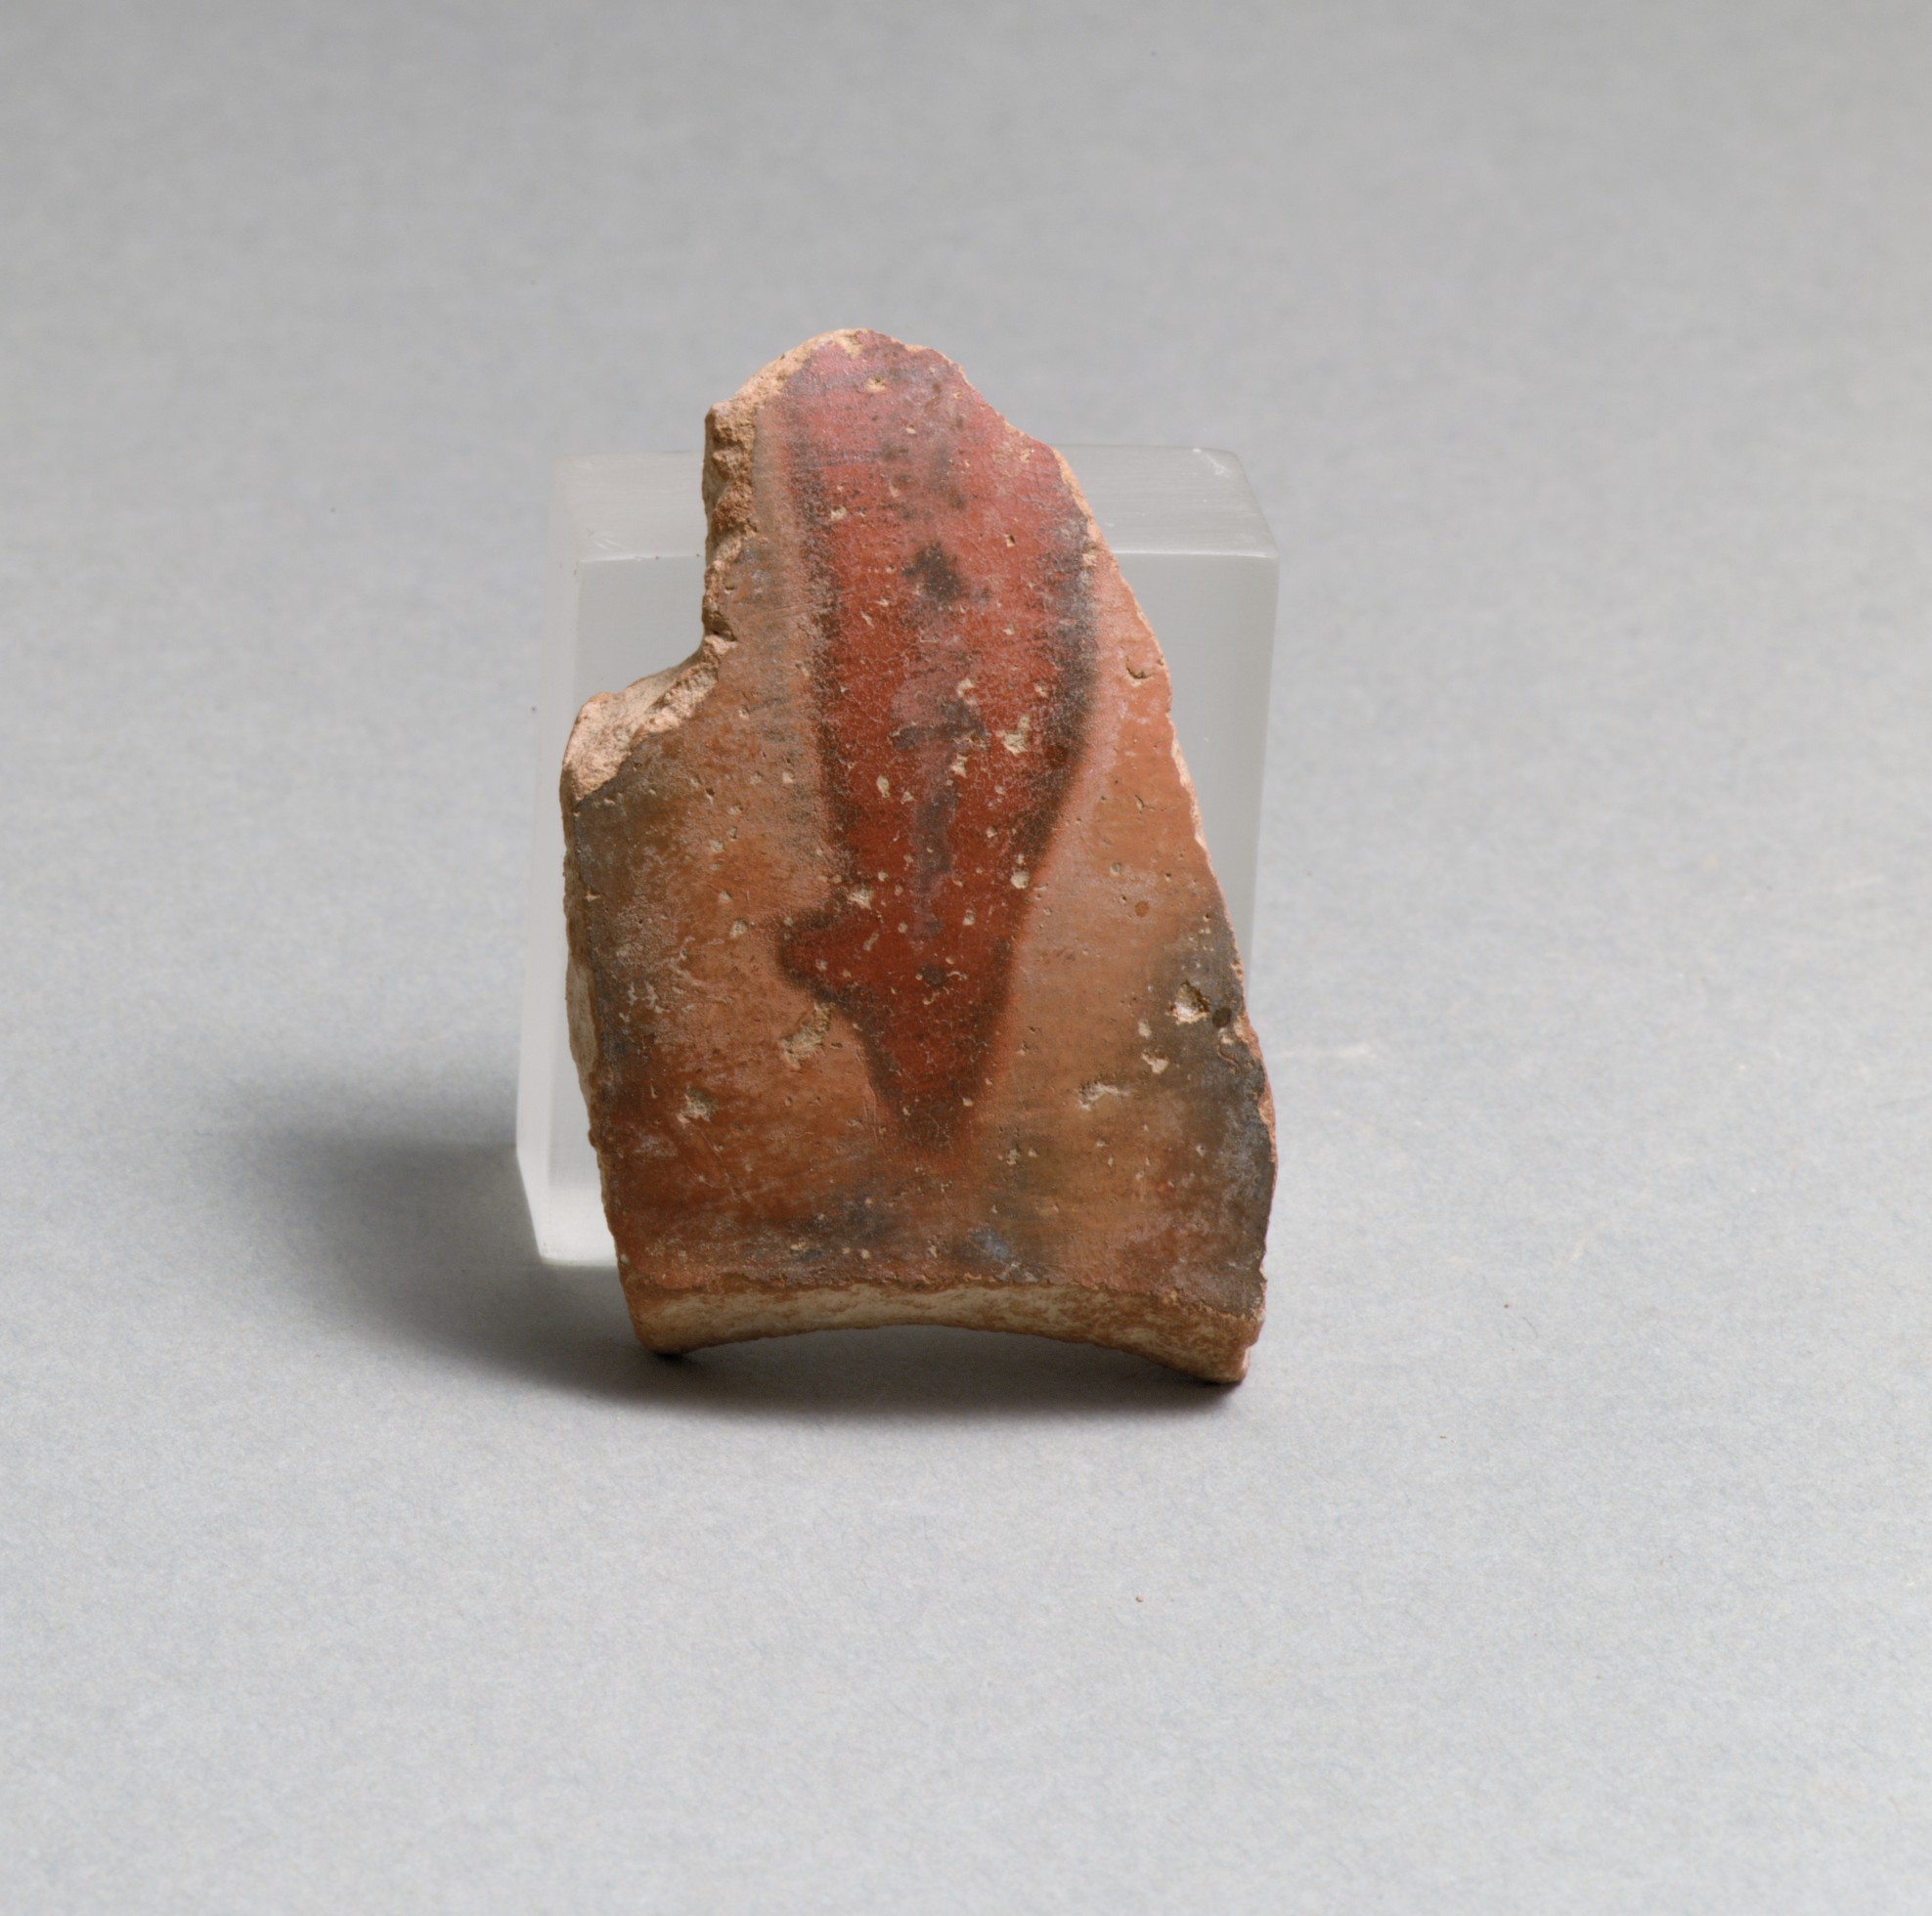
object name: vase fragment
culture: minoan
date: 2600-2000 BCE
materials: terracotta